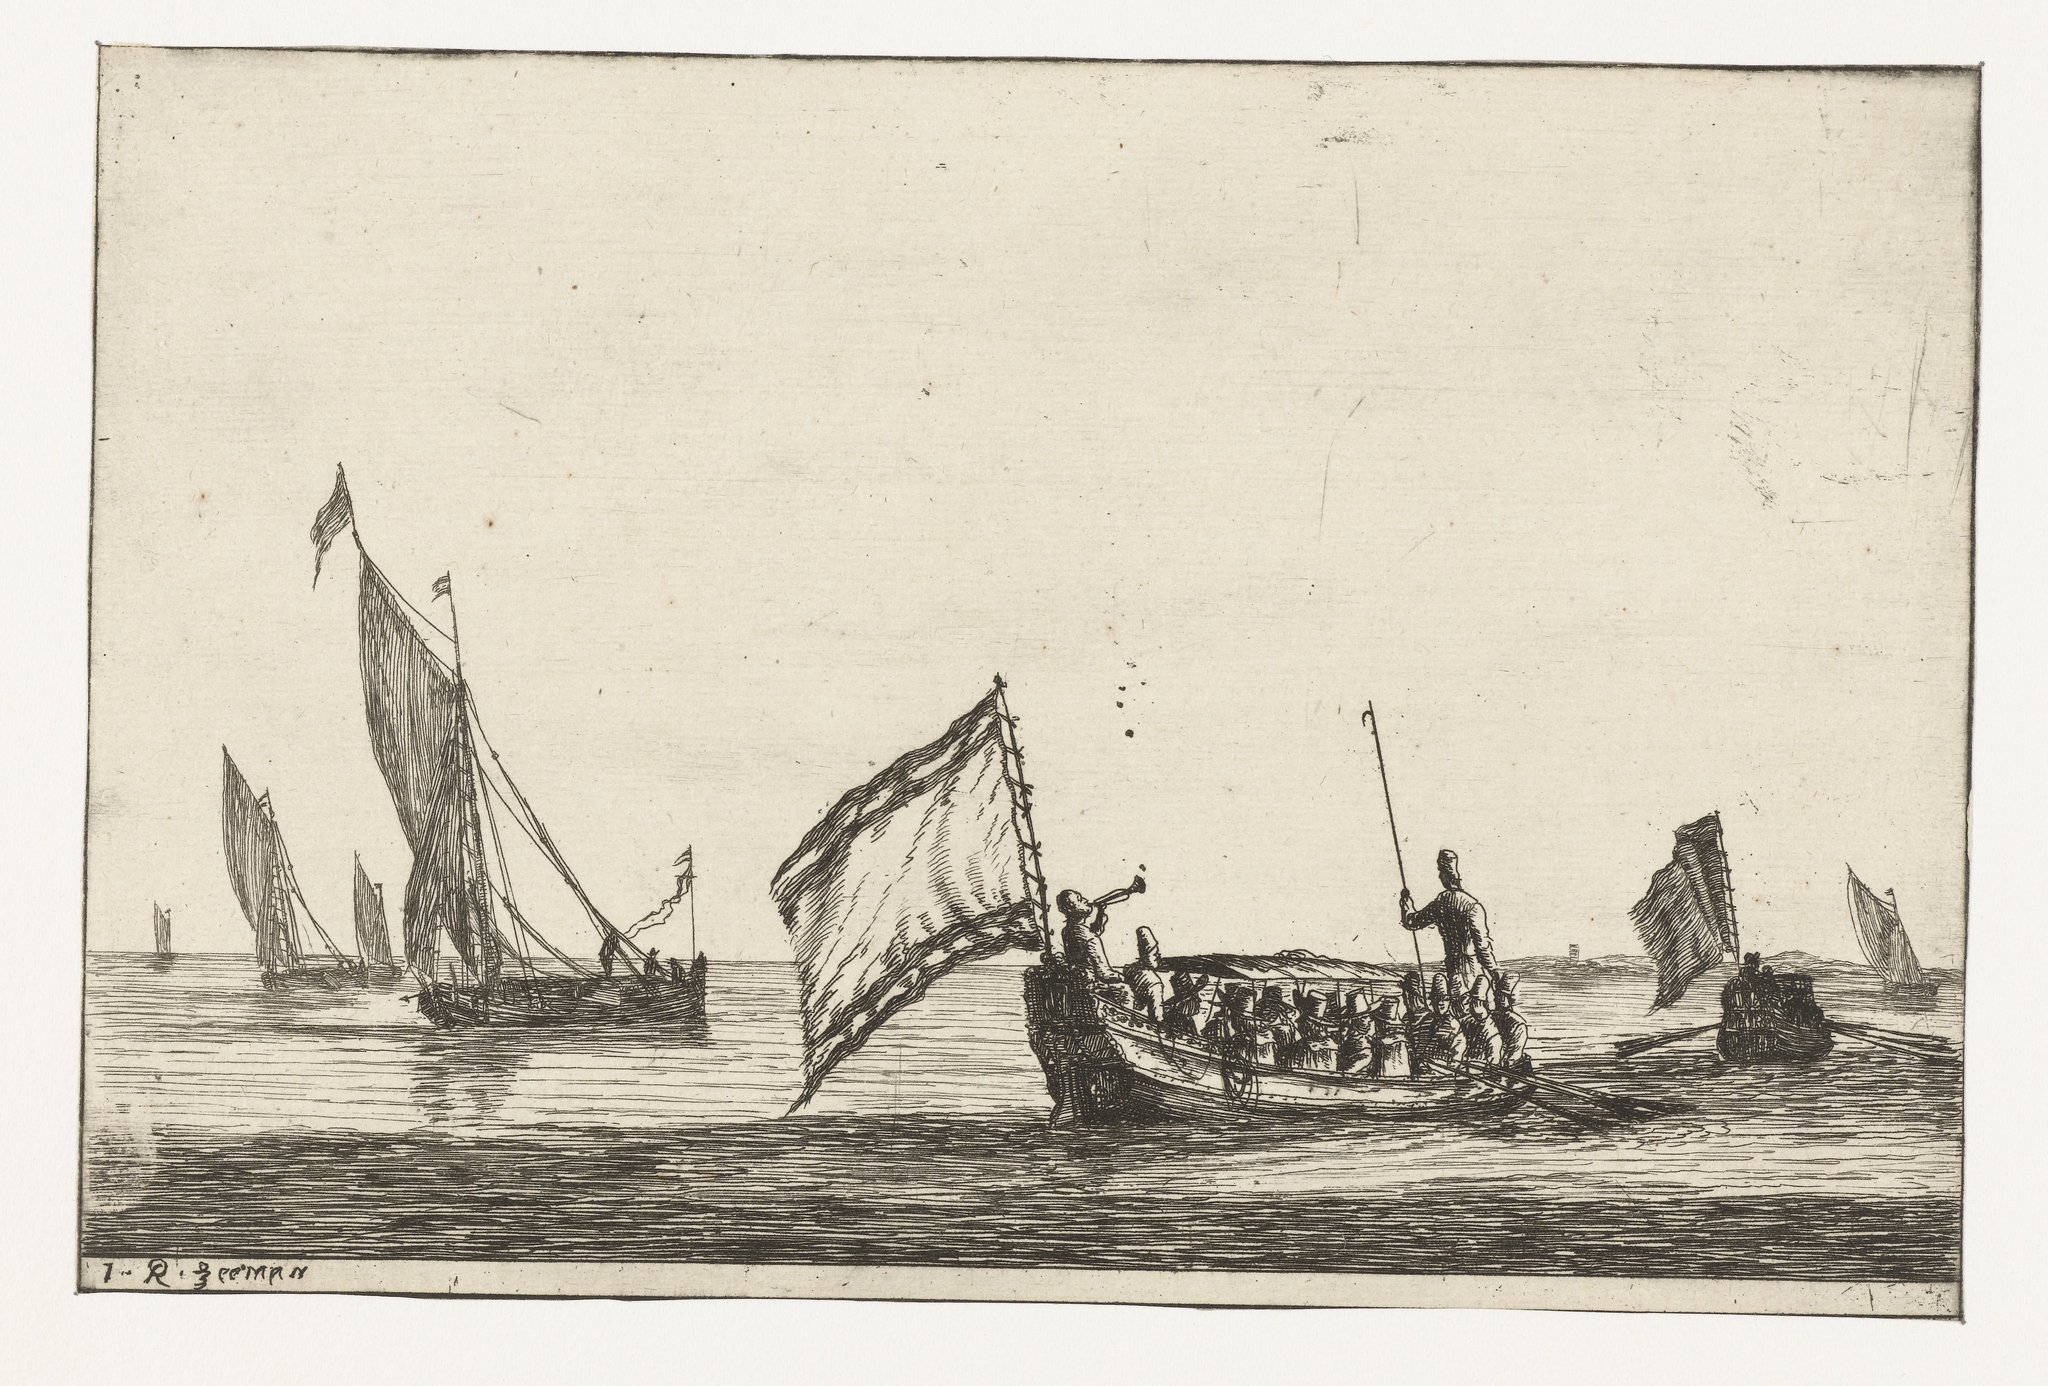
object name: print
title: Statensloep en zeilschepen op kalm water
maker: reinier nooms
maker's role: draughtsman, painter, print maker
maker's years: 1623-1664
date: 1654-1658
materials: paper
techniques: etching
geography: netherlands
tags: sailing-ship, sailing-boat, rowing-boat, canoe, etc.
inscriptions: collector's mark: Lugt 12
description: Twee statensloepen, gebruikt op hooggeplaatste figuren te vervoeren, met een baldakijn en een vlag, en een aantal zeilschepen. Titelblad vóór de toevoeging van een zeil met de titel.